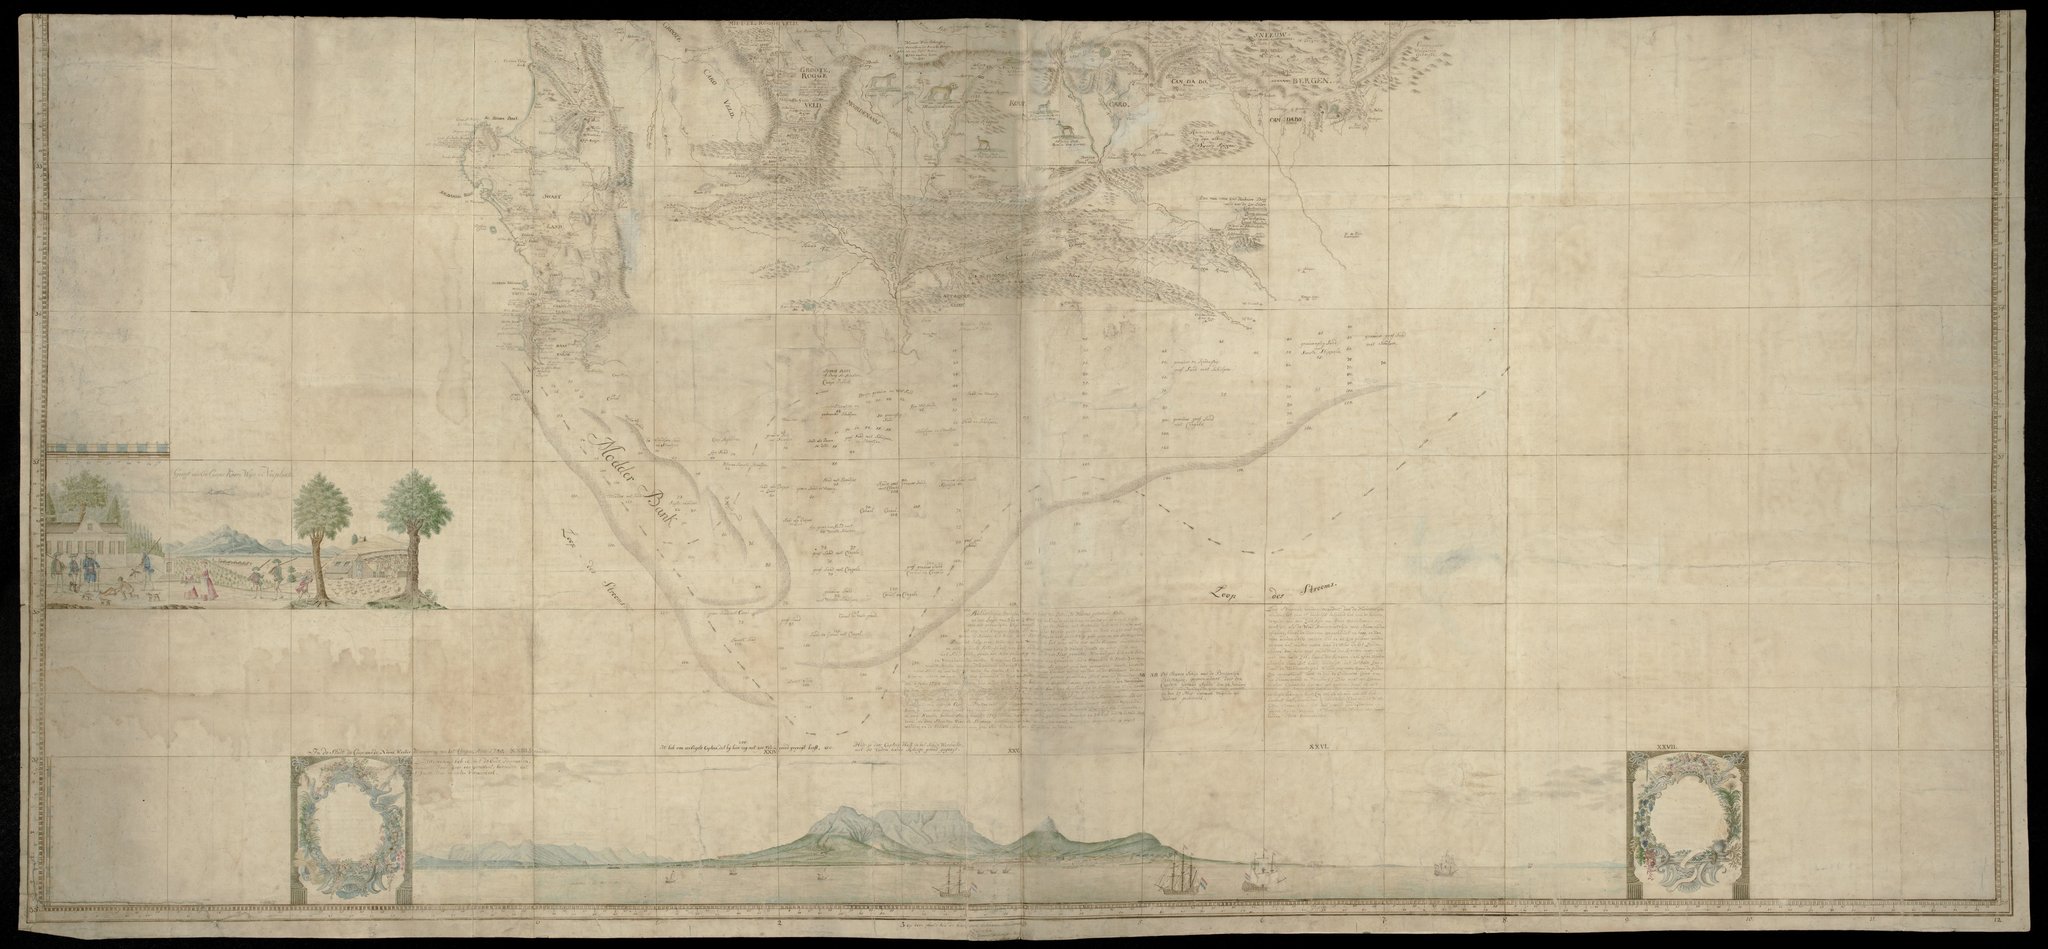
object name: map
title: Lower (southern) half of Gordon's great map of Southern Africa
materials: ink, paper, pencil, watercolor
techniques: brush, pen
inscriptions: annotation: ‘zie De Jong’